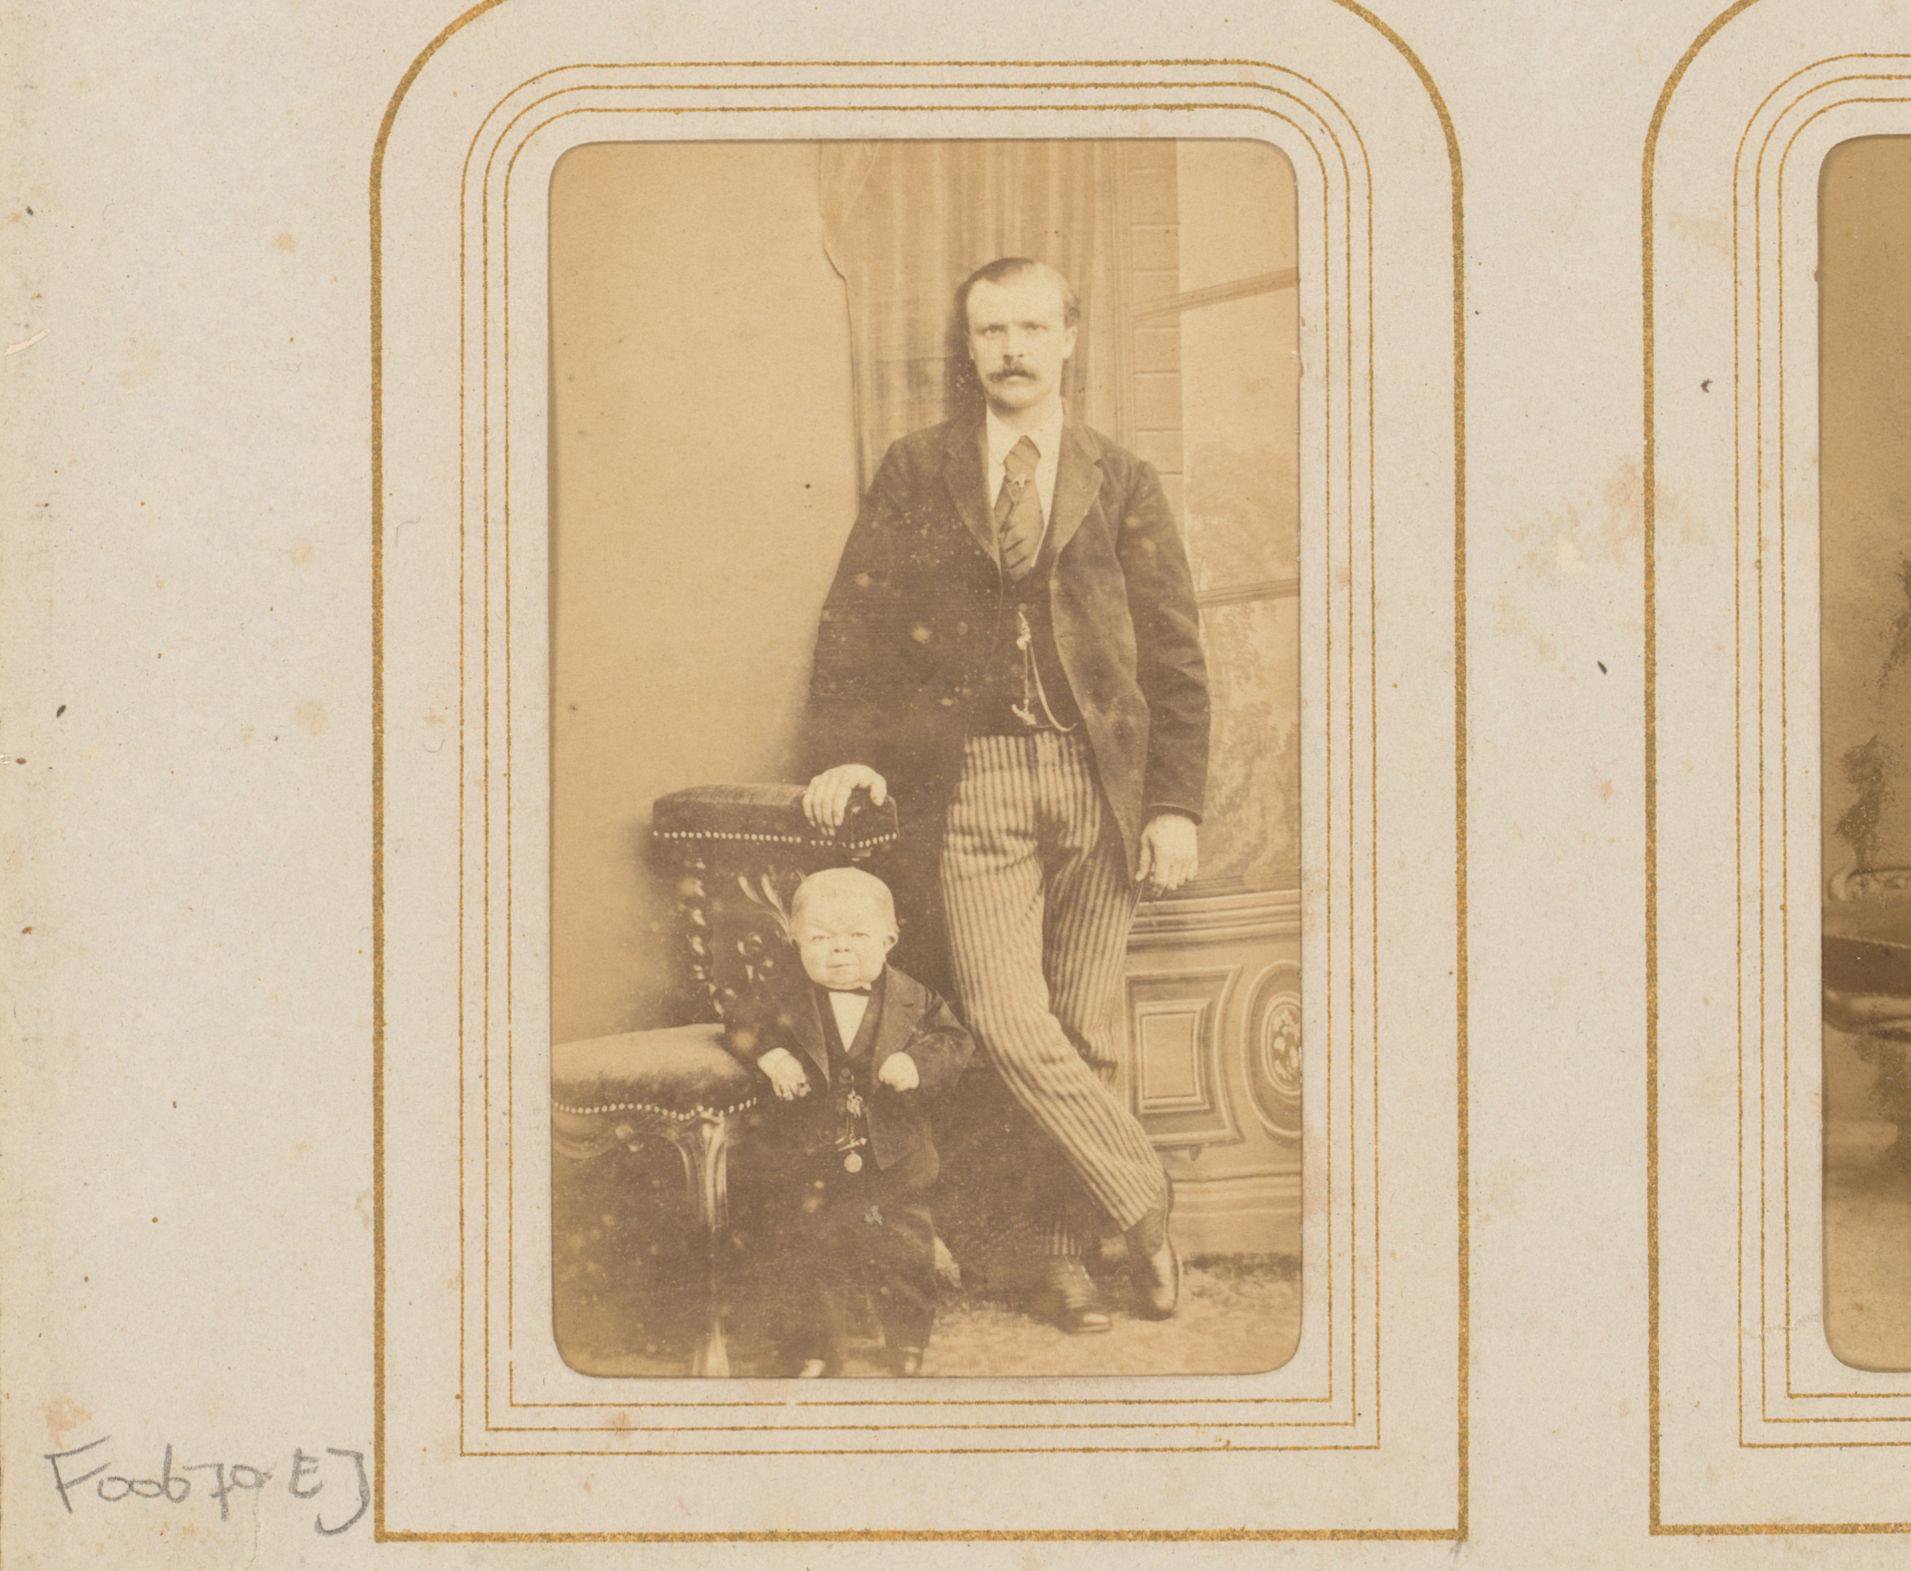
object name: photograph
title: Portret van twee mannen, waarvan één met dwerggroei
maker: pieter siewers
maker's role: fotograaf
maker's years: 1819-1898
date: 1860-1880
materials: cardboard, photographic support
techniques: albumen print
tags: little people, historical persons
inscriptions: annotation: ‘man en zoon/ (P. Siewers & Zoon, Edam, Purmerend)’, inscription: ‘Photographisch Atelier/ P. Siewers & Zoon/ Edam en Purmerend (...)’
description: Portret van twee mannen, waarvan één met dwerggroei. Deze foto maakt deel uit van een album.